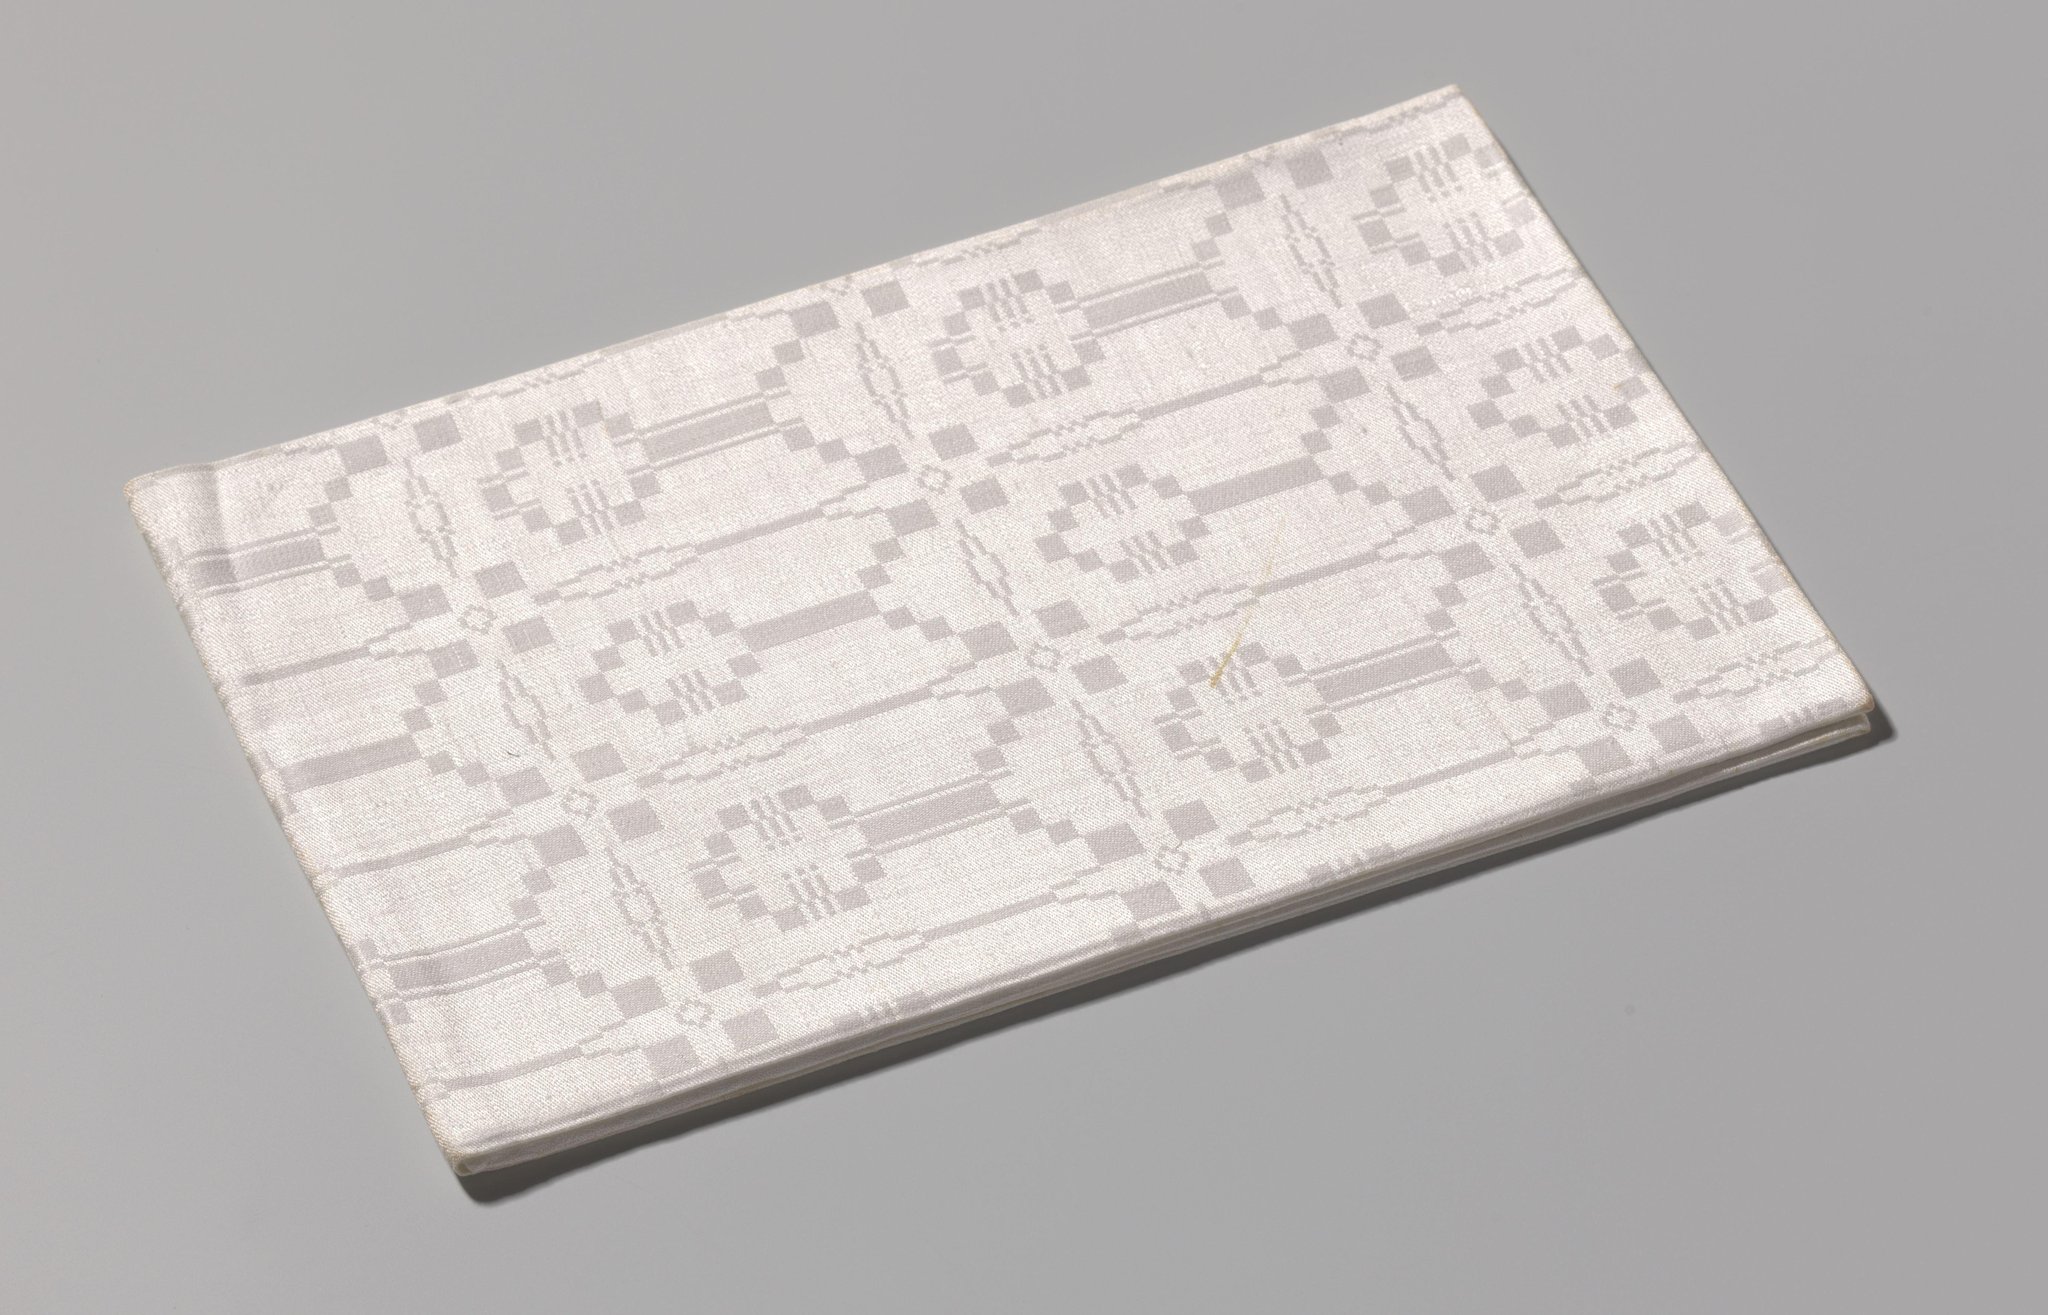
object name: napkin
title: Servet van linnen met pellenpatroon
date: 1726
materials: linen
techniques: peeled fabric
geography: northern netherlands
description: wit linnen servet met pellen patroon, merk GS 60 en 1726